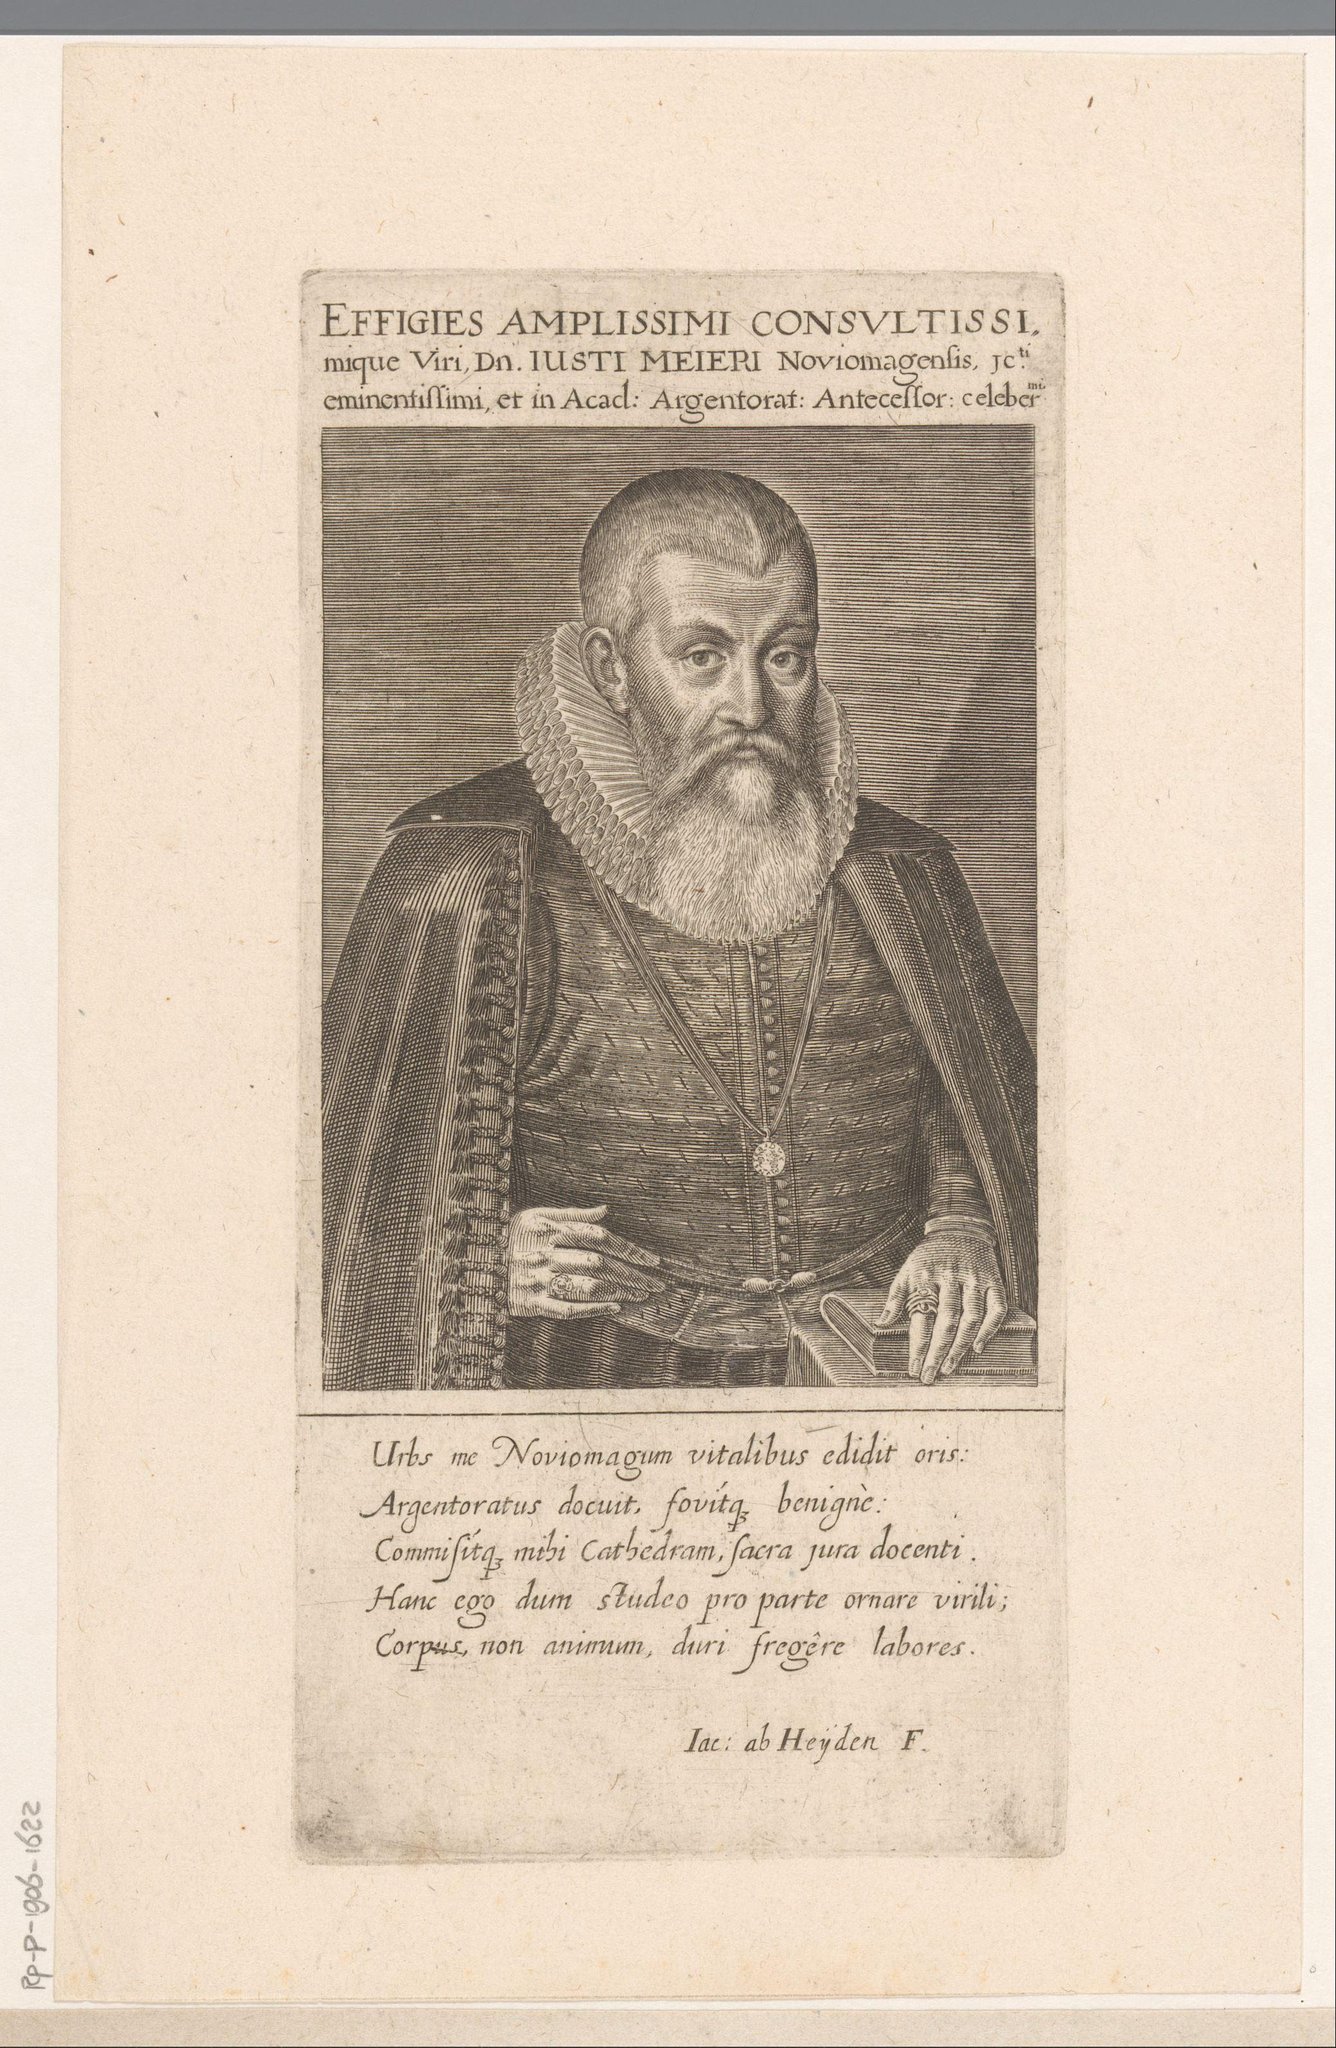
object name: print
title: Portret van Justus Meier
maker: jacob van der heyden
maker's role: draughtsman, print maker, publisher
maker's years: 1573-1645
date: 1583-1622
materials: paper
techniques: engraving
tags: historical persons, pendant, trinket, 'breloque', book, ring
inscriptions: collector's mark: Lugt 2228